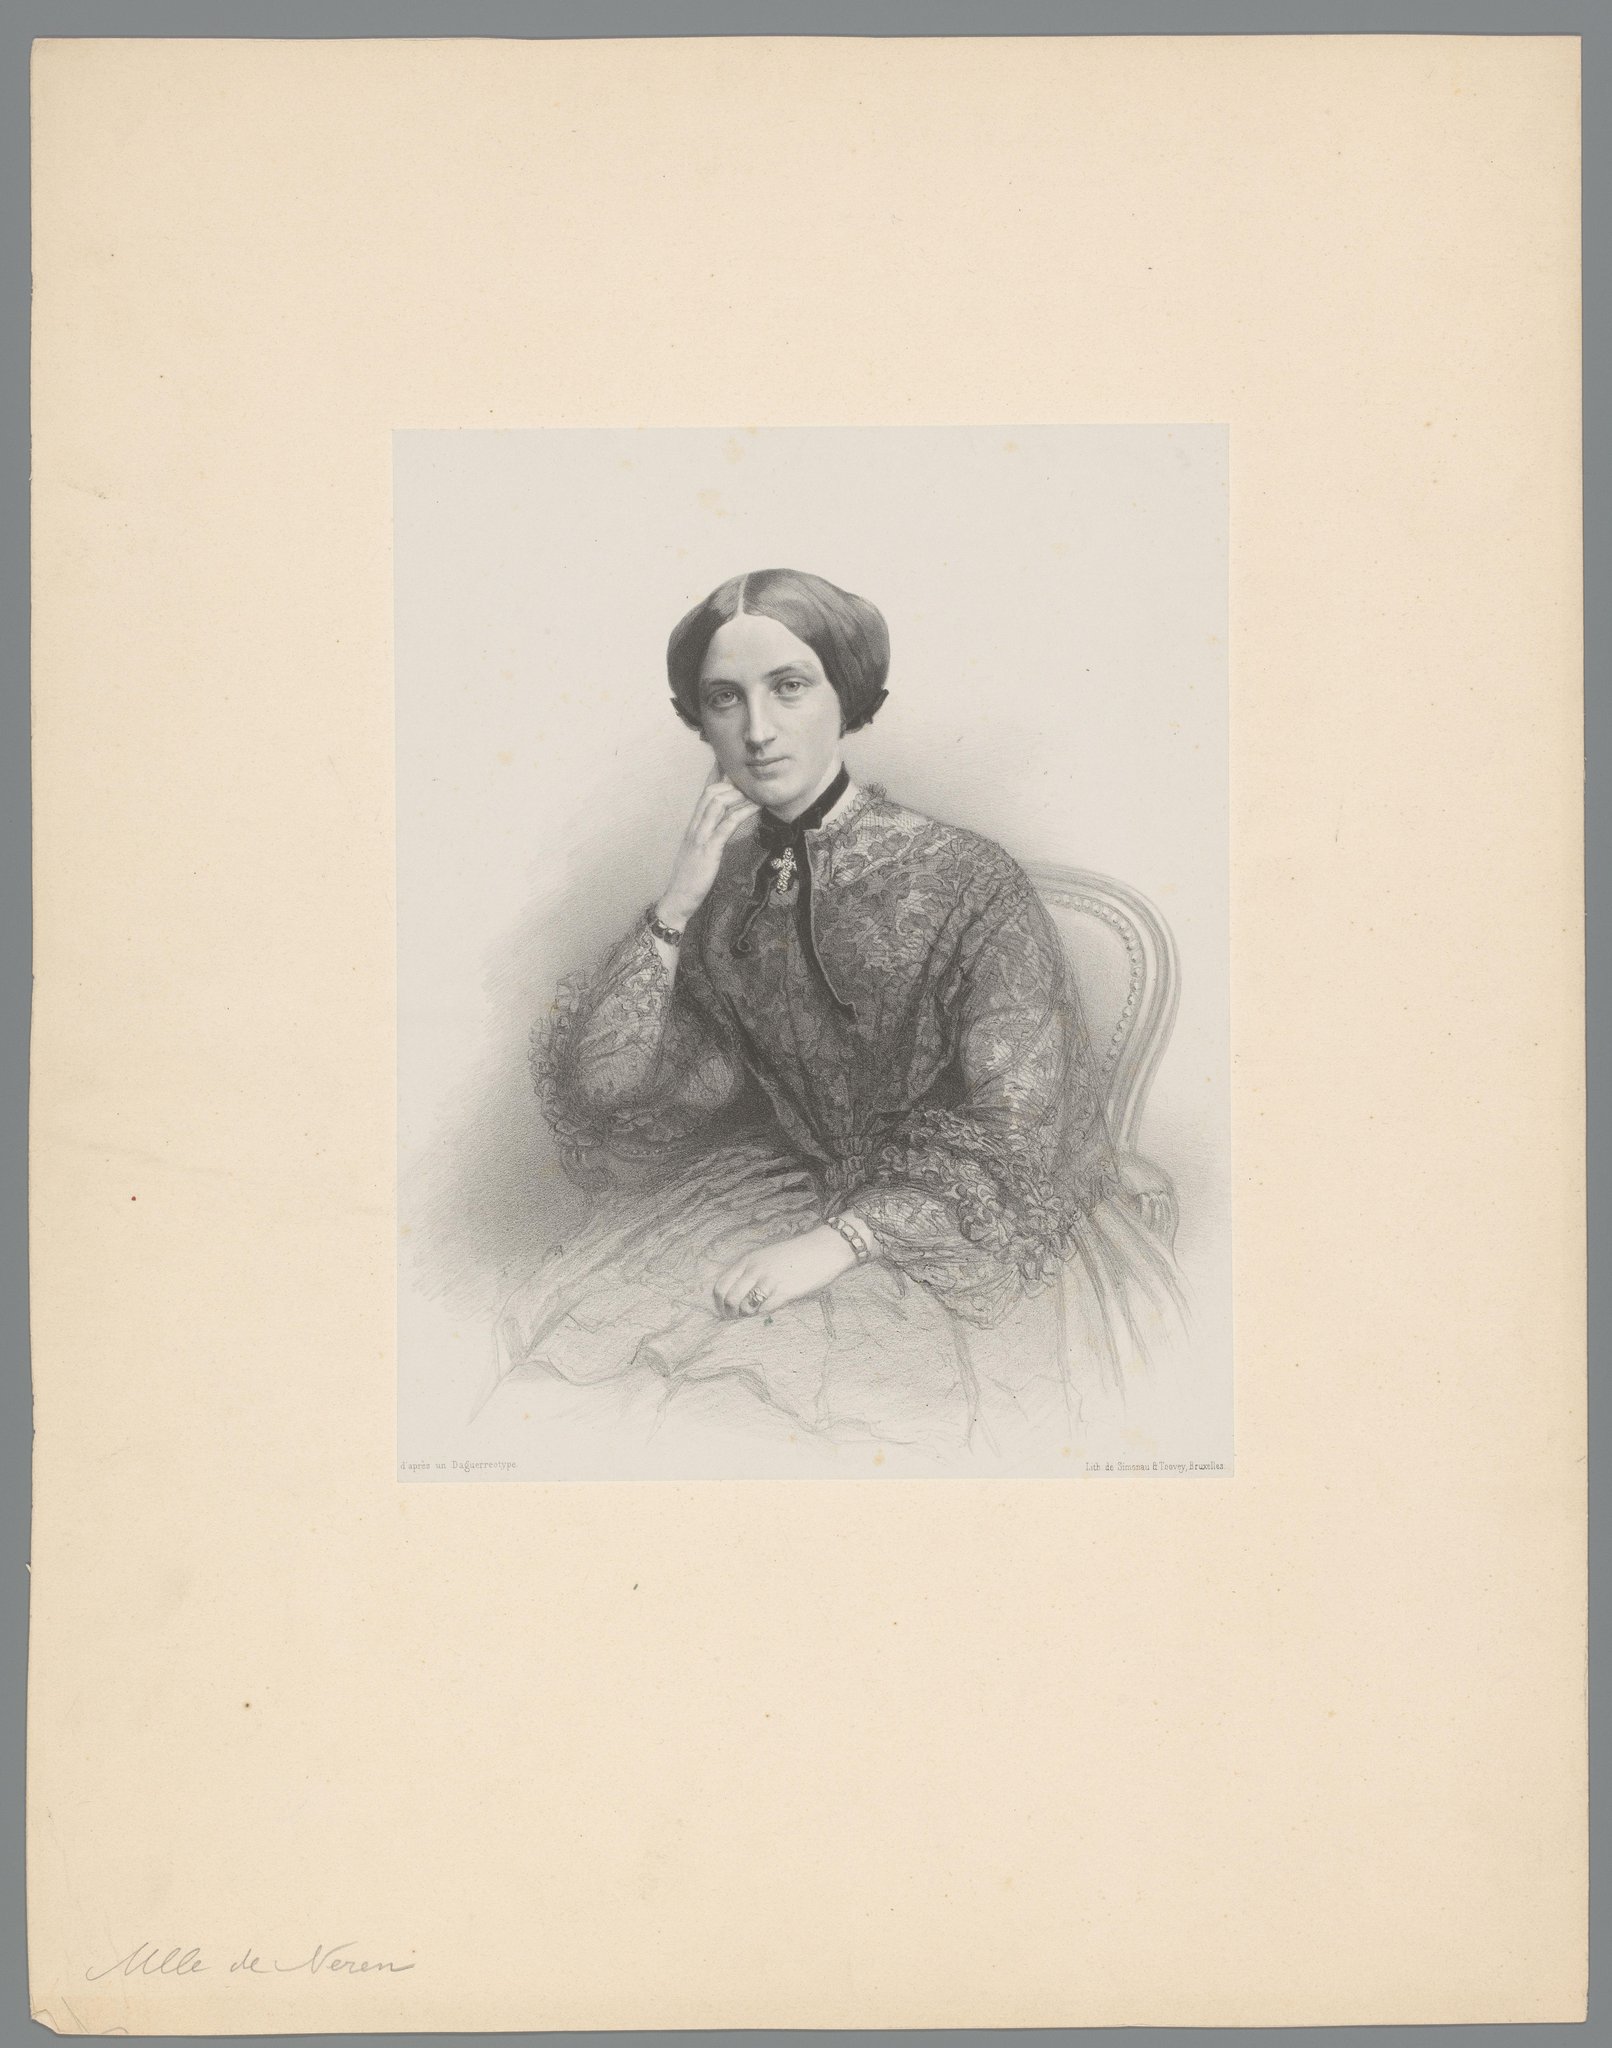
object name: print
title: Portret van juffrouw Neven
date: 1847-1875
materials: paper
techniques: lithograph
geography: brussels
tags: historical persons - bb - woman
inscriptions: collector's mark: Lugt 2228